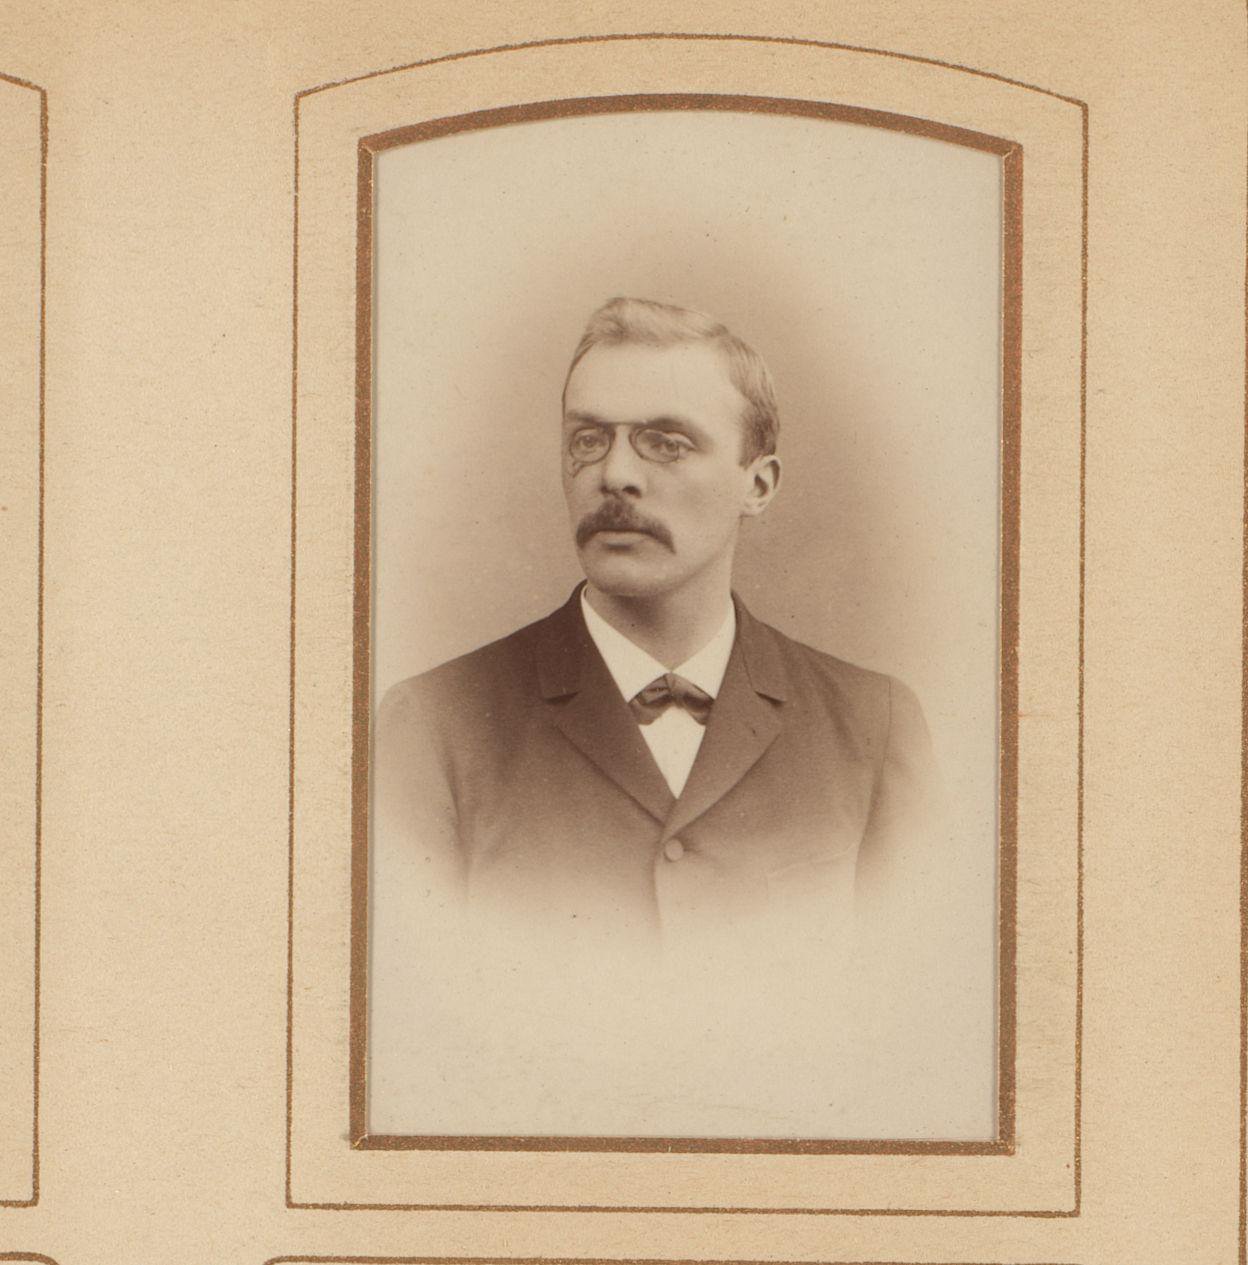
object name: photograph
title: Portret van een man met snor en bril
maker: Anonymous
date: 1870-1900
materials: cardboard, photographic support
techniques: albumen print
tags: eyeglasses, spectacles, moustache, historical persons